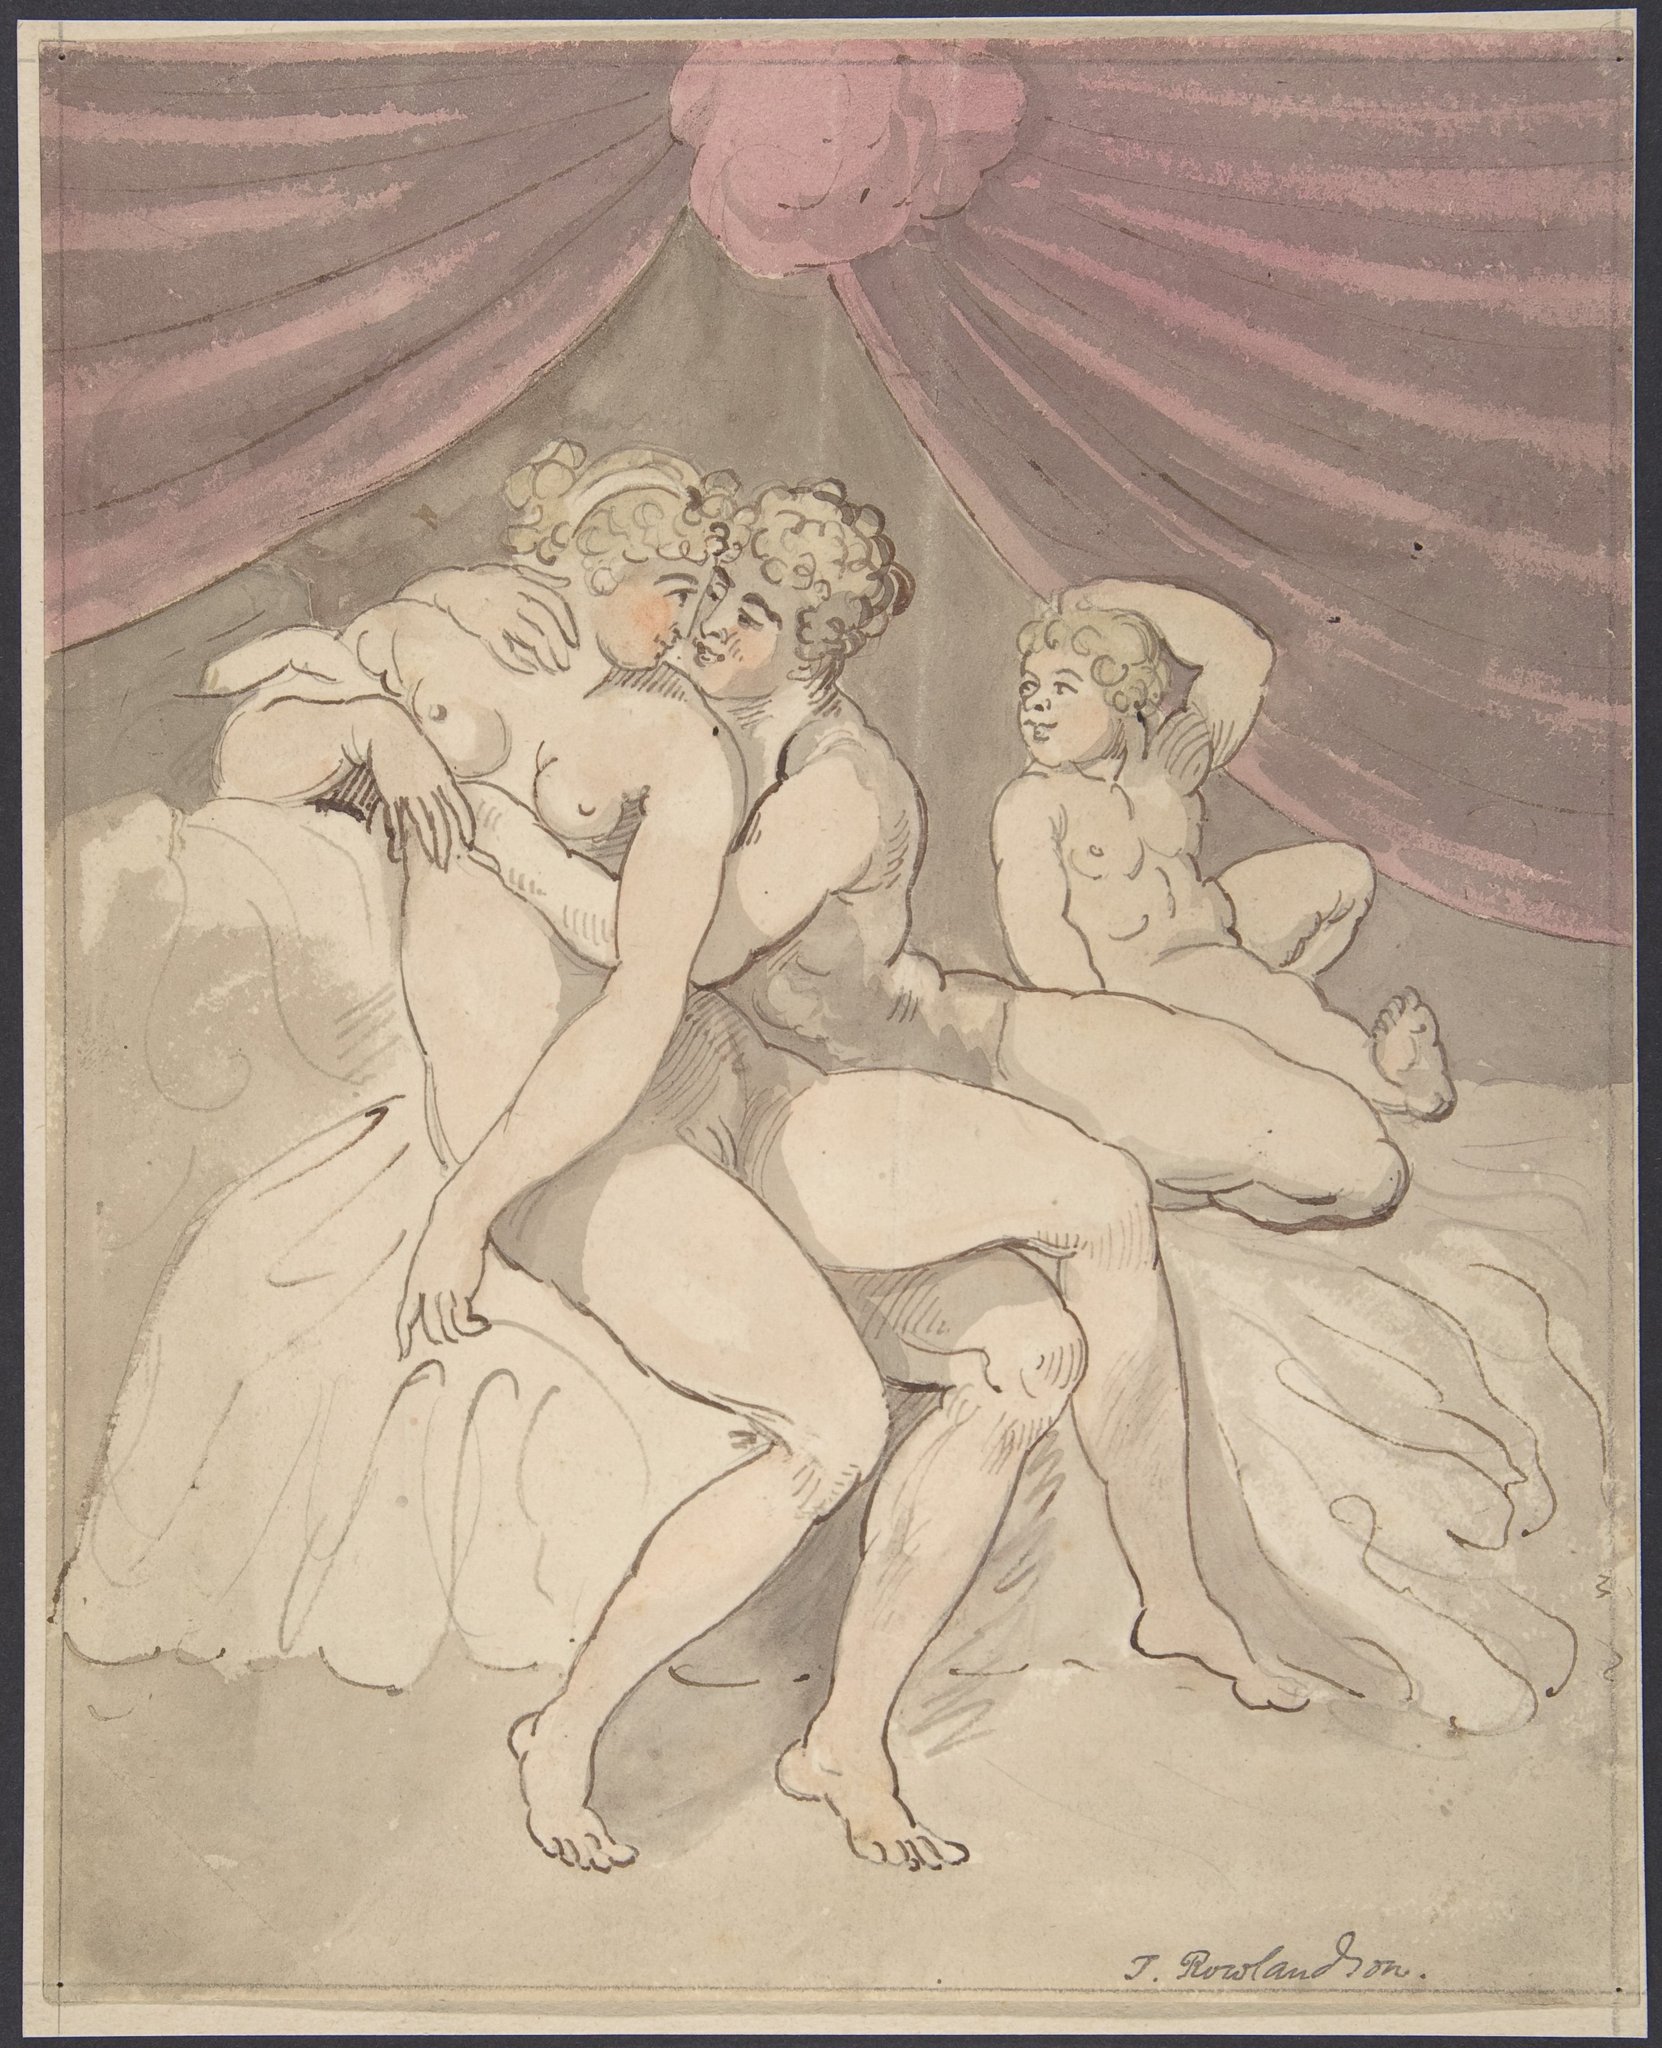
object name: drawing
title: Nude Couple Embracing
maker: thomas rowlandson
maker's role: artist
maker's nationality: british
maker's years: 1757-1827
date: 1780-1827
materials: watercolor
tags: couples,male nudes,female nudes